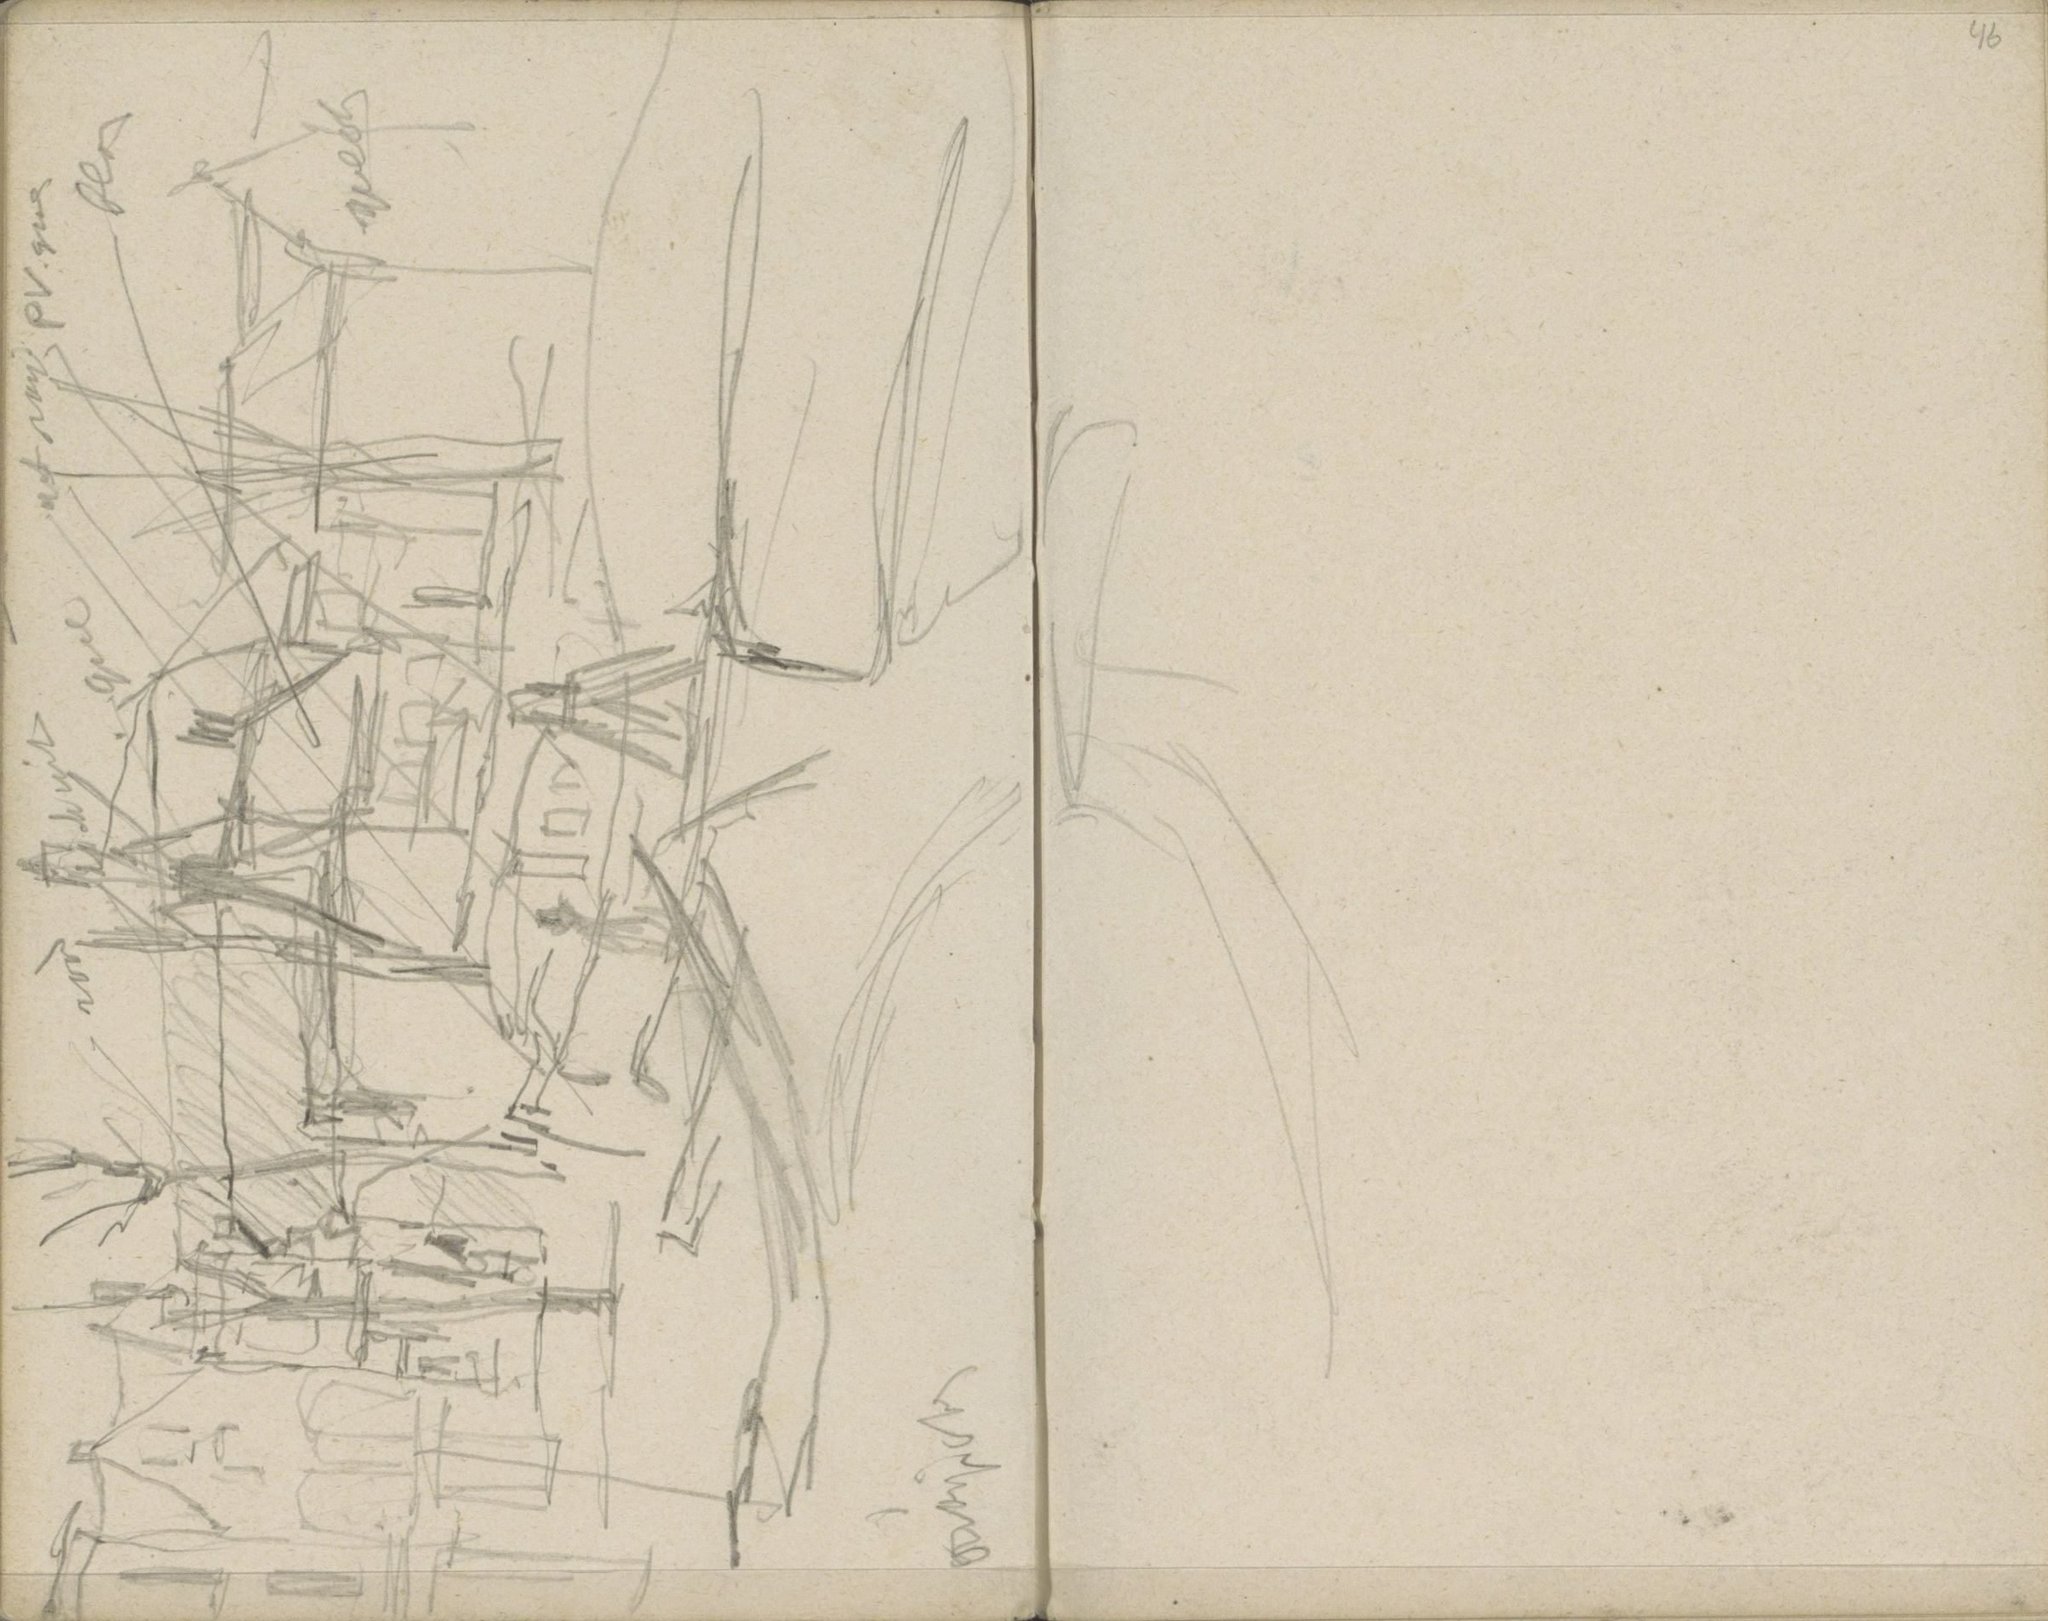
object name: sketchbook leaf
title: Gezicht in Amsterdam met een aanlegplaats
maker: george hendrik breitner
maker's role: draughtsman, painter, print maker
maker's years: 1857-1923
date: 1914-1923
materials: paper, pencil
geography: amsterdam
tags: urban housing, city-view, and landscape with man-made constructions, ships (in general), church (exterior), amsterdam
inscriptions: annotation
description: Gezicht in Amsterdam met een aanlegplaats. Op de achtergrond mogelijk een kerk. Pagina 45 en pagina 46 uit een schetsboek met 43 bladen vervaardigd te Amsterdam.